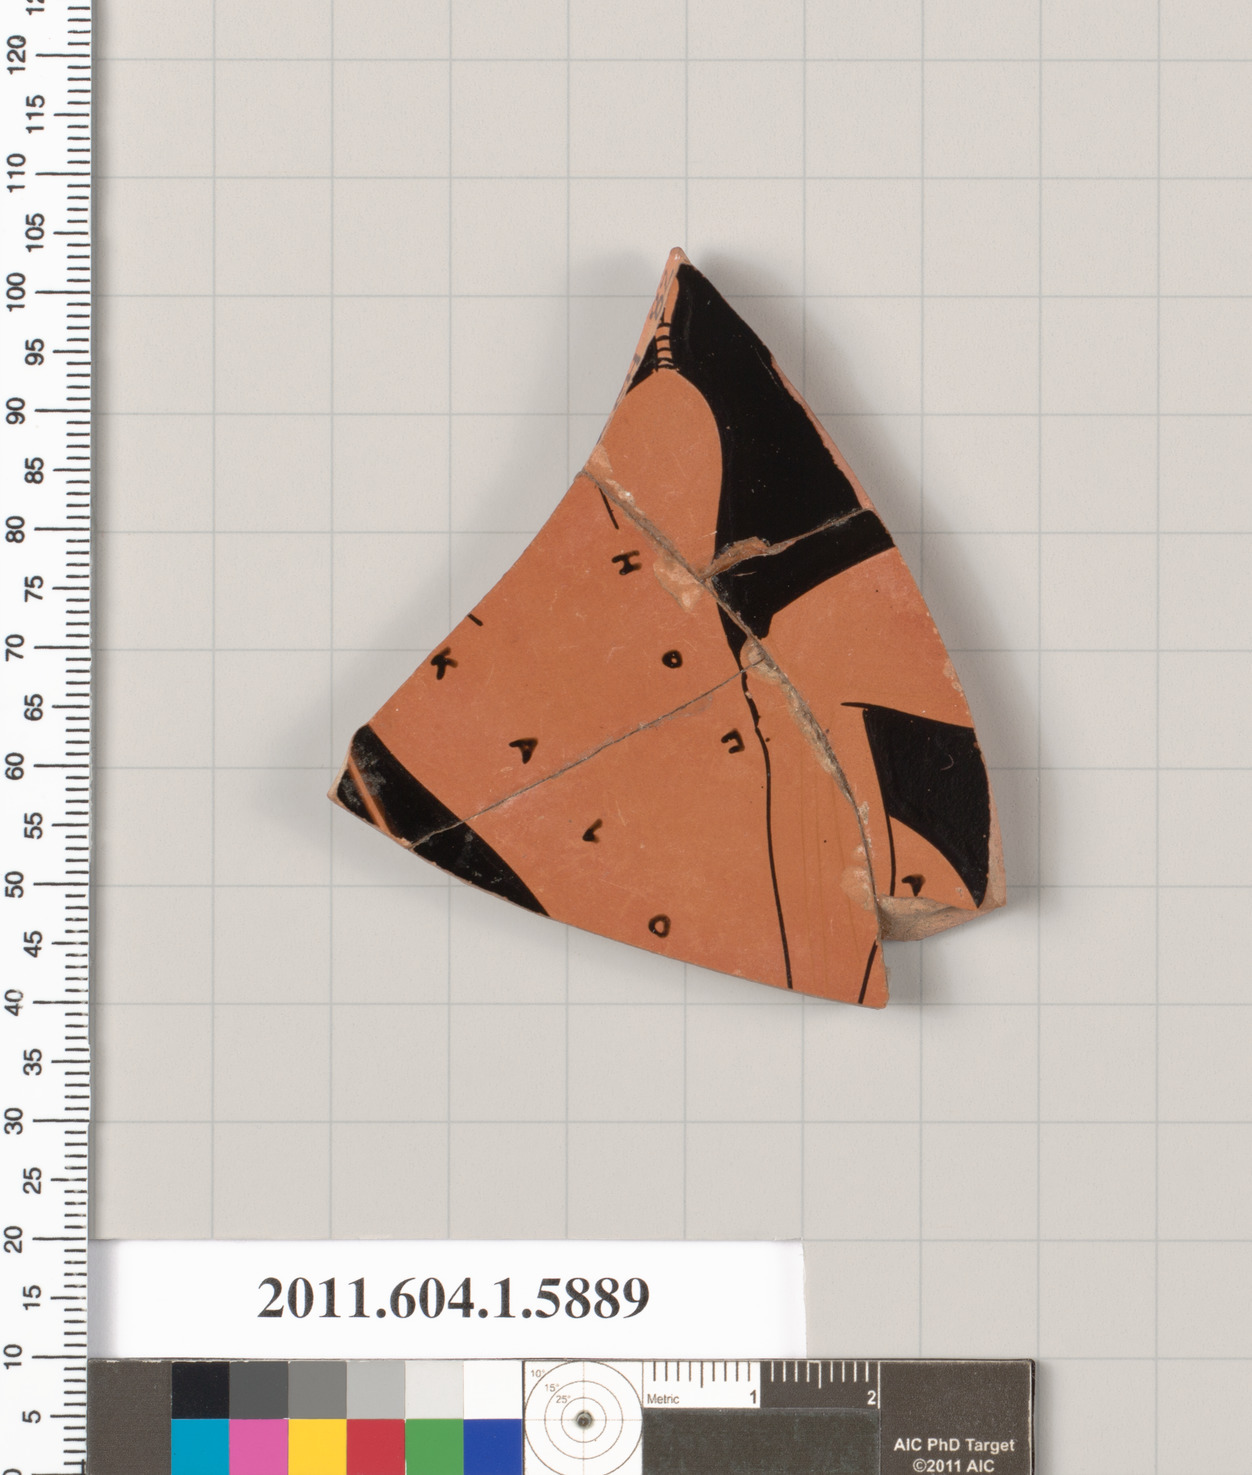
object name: kylix fragment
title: Terracotta fragment of a kylix (drinking cup)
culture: greek, attic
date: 520-510 BCE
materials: terracotta